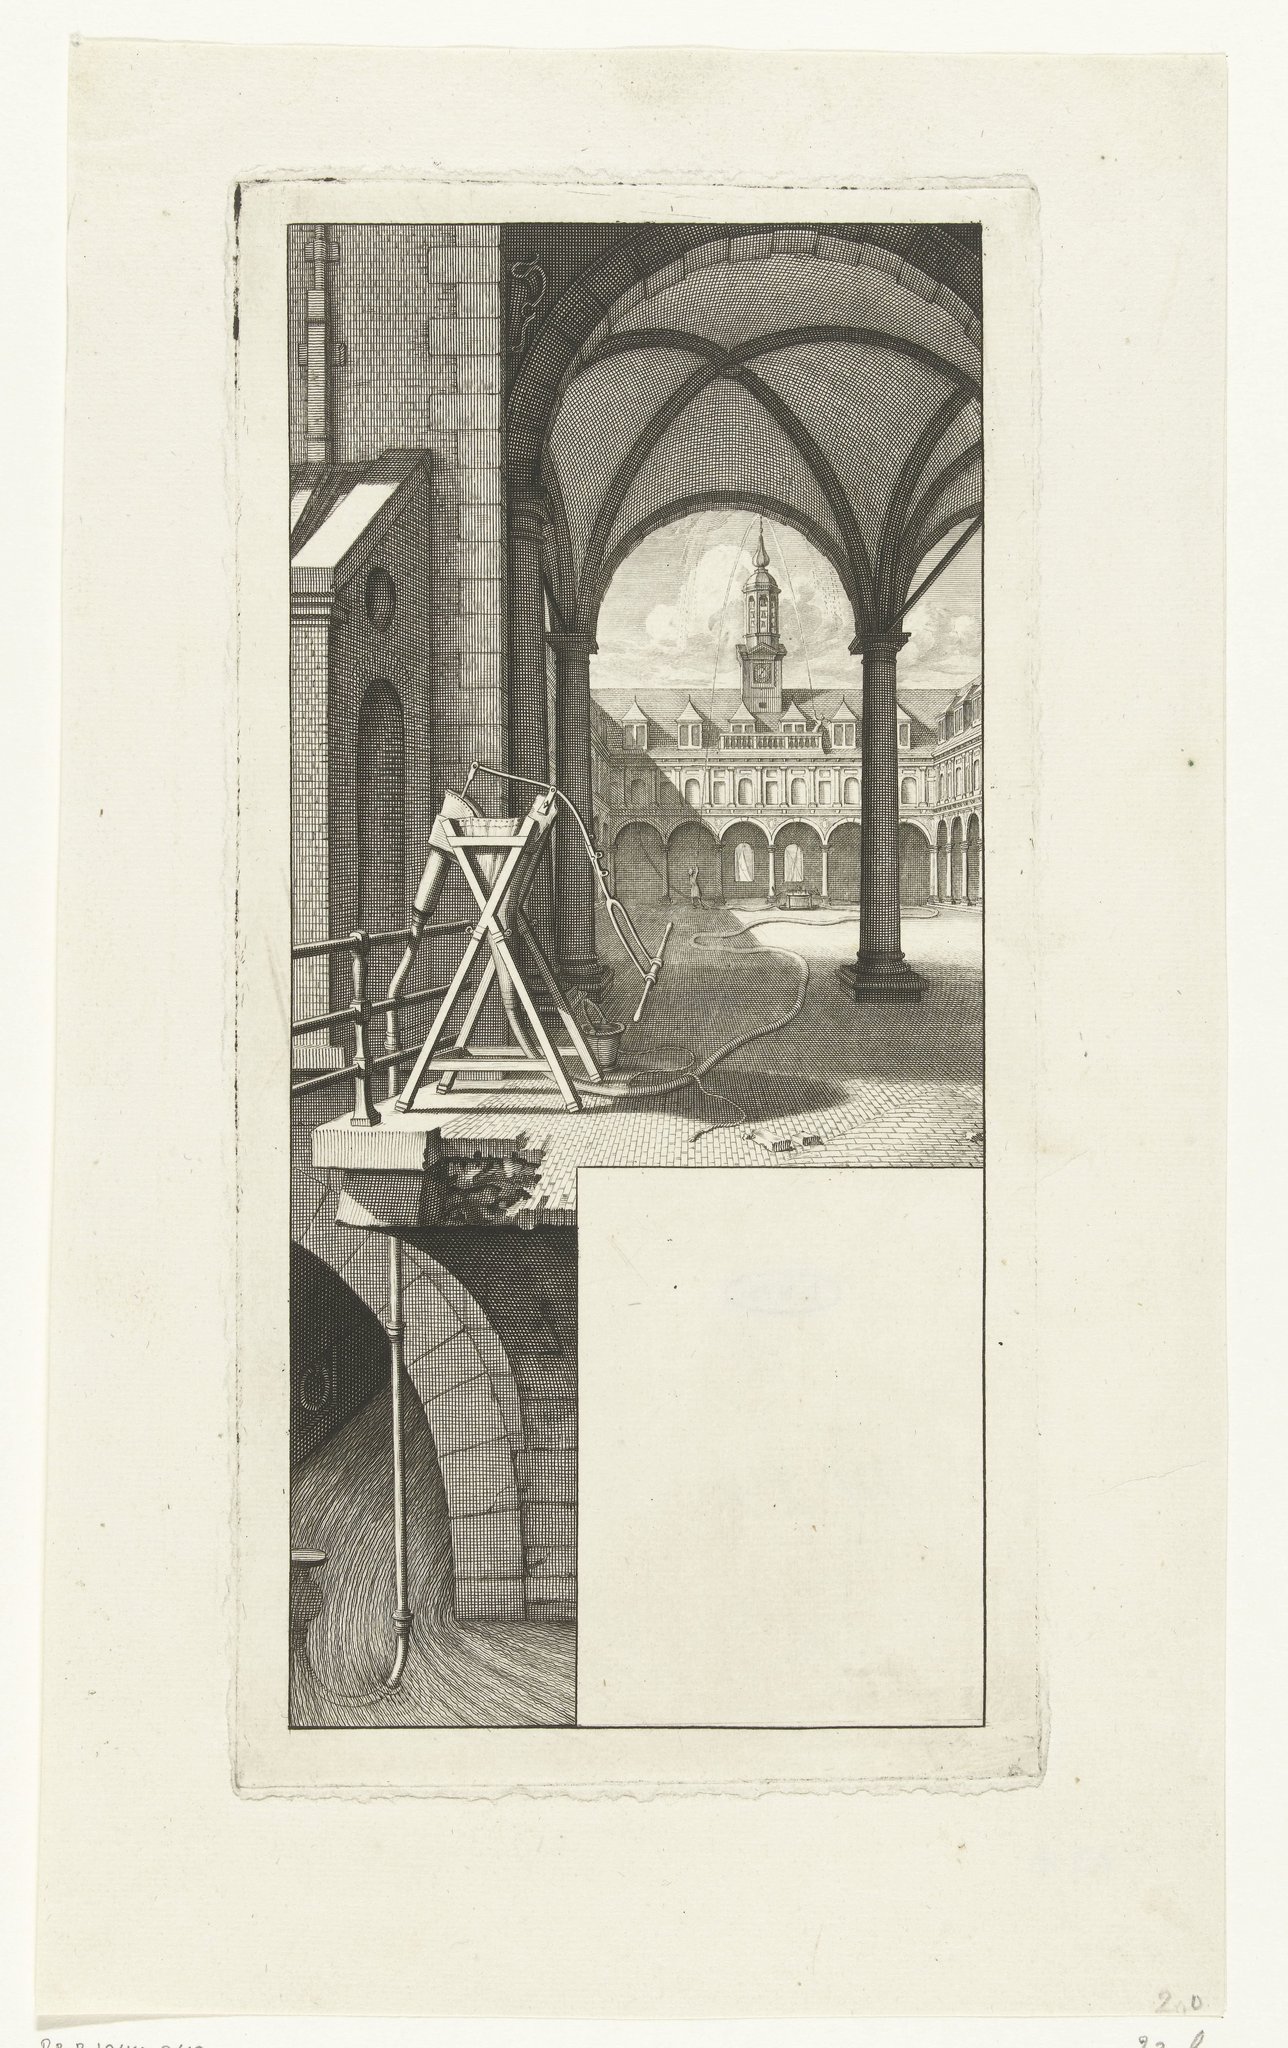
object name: print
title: Demonstratie van de slangbrandspuiten op het binnenplein van de Beurs te Amsterdam, ca. 1670-1680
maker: laurens scherm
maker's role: draughtsman, print maker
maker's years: 1671-1702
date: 1690-1702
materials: paper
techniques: engraving, etching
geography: amsterdam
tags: amsterdam, painter, print maker, draughtsman, jan van der heyden, pump (fire-extinguishing equipment), exchange, bourse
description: Latere staat prent ook gebruikt in: Heyden, Jan van der. Beschryving der nieuwlyks uitgevonden en geoctrojeerde slang-brand-spuiten en haare wyze van brand-blussen, tegenwoordig binnen Amsterdam in gebruik zijnde (…). 2e druk. Amsterdam: erfgenamen Jan van der Heyden, 1735.